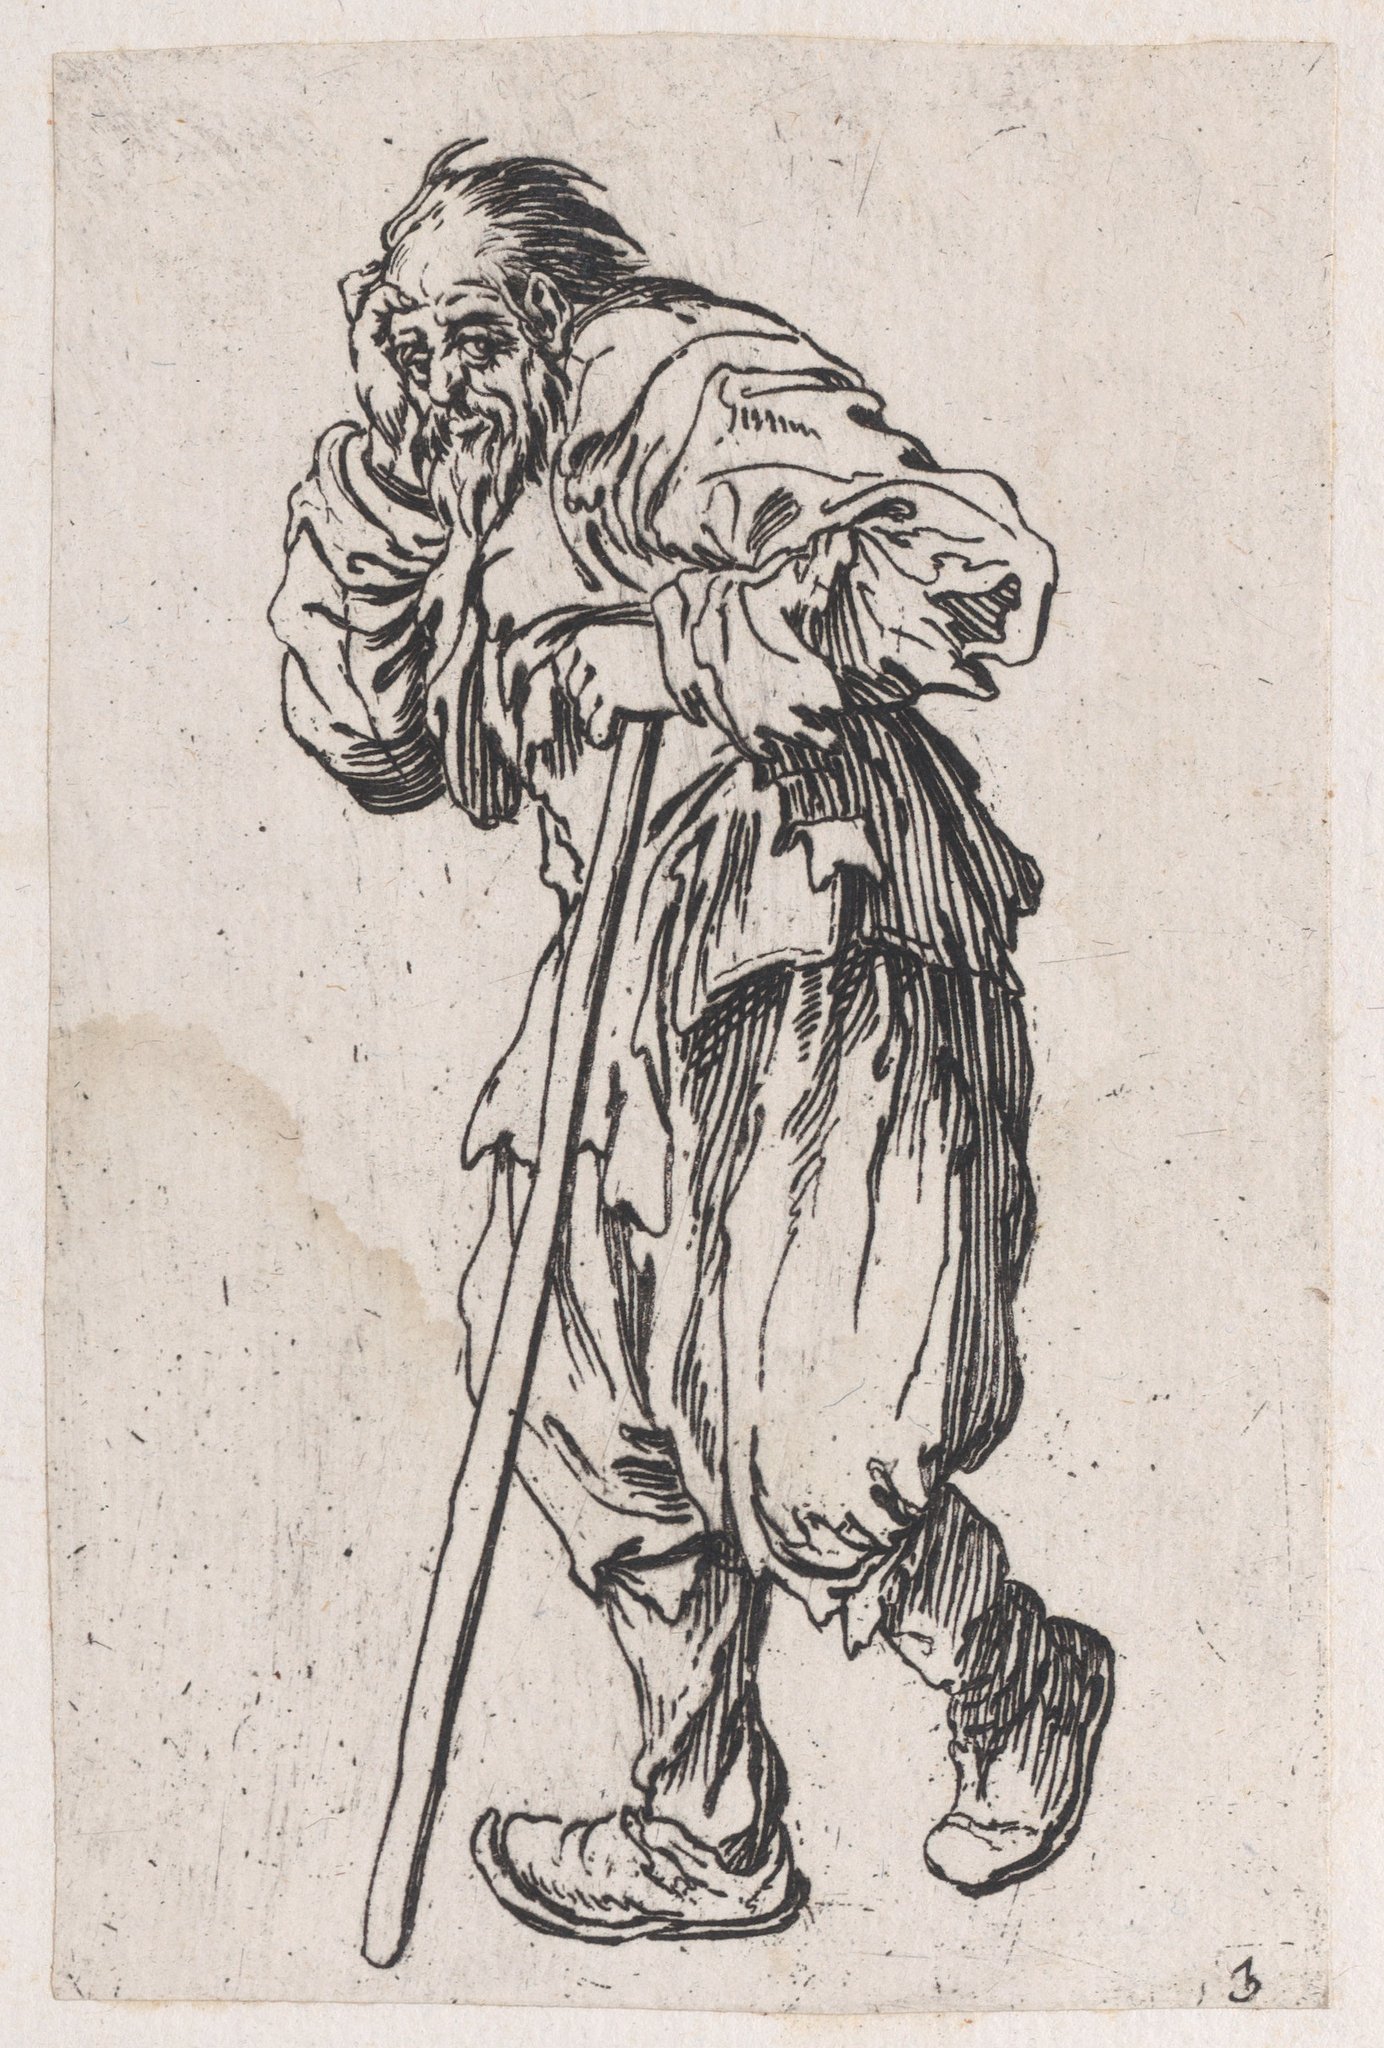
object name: print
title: Reverse Copy of Le Gueux Appuyé sur son Baton (The Beggar Leaning on His Cane), from Les Gueux suite appelée aussi Les Mendiants, Les Baroni, ou Les Barons (The Beggars, also called the Barons)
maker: Anonymous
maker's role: artist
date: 1601-1700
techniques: etching